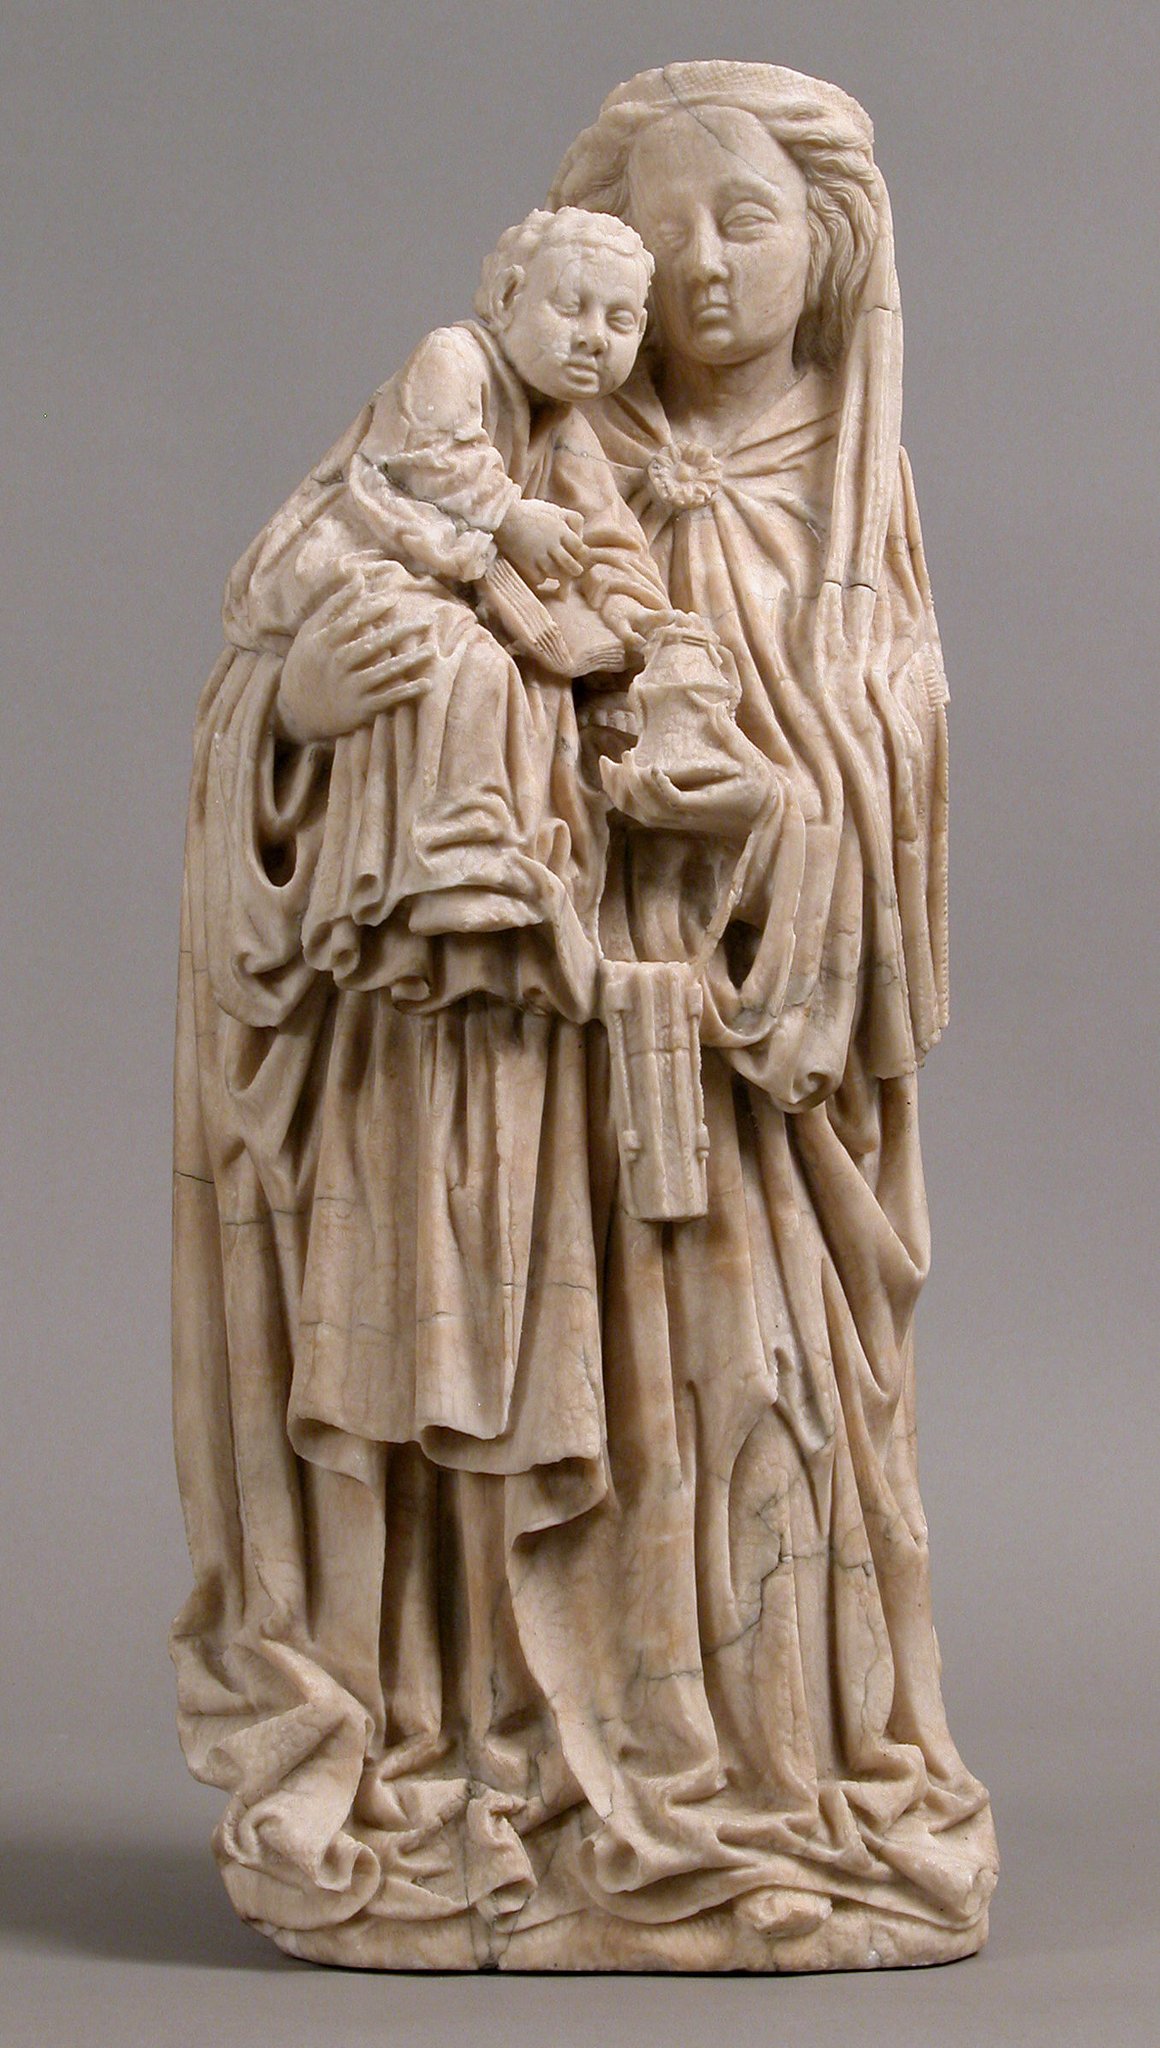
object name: statuette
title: Virgin and Child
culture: french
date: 1451-1500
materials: alabaster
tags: christ,virgin mary